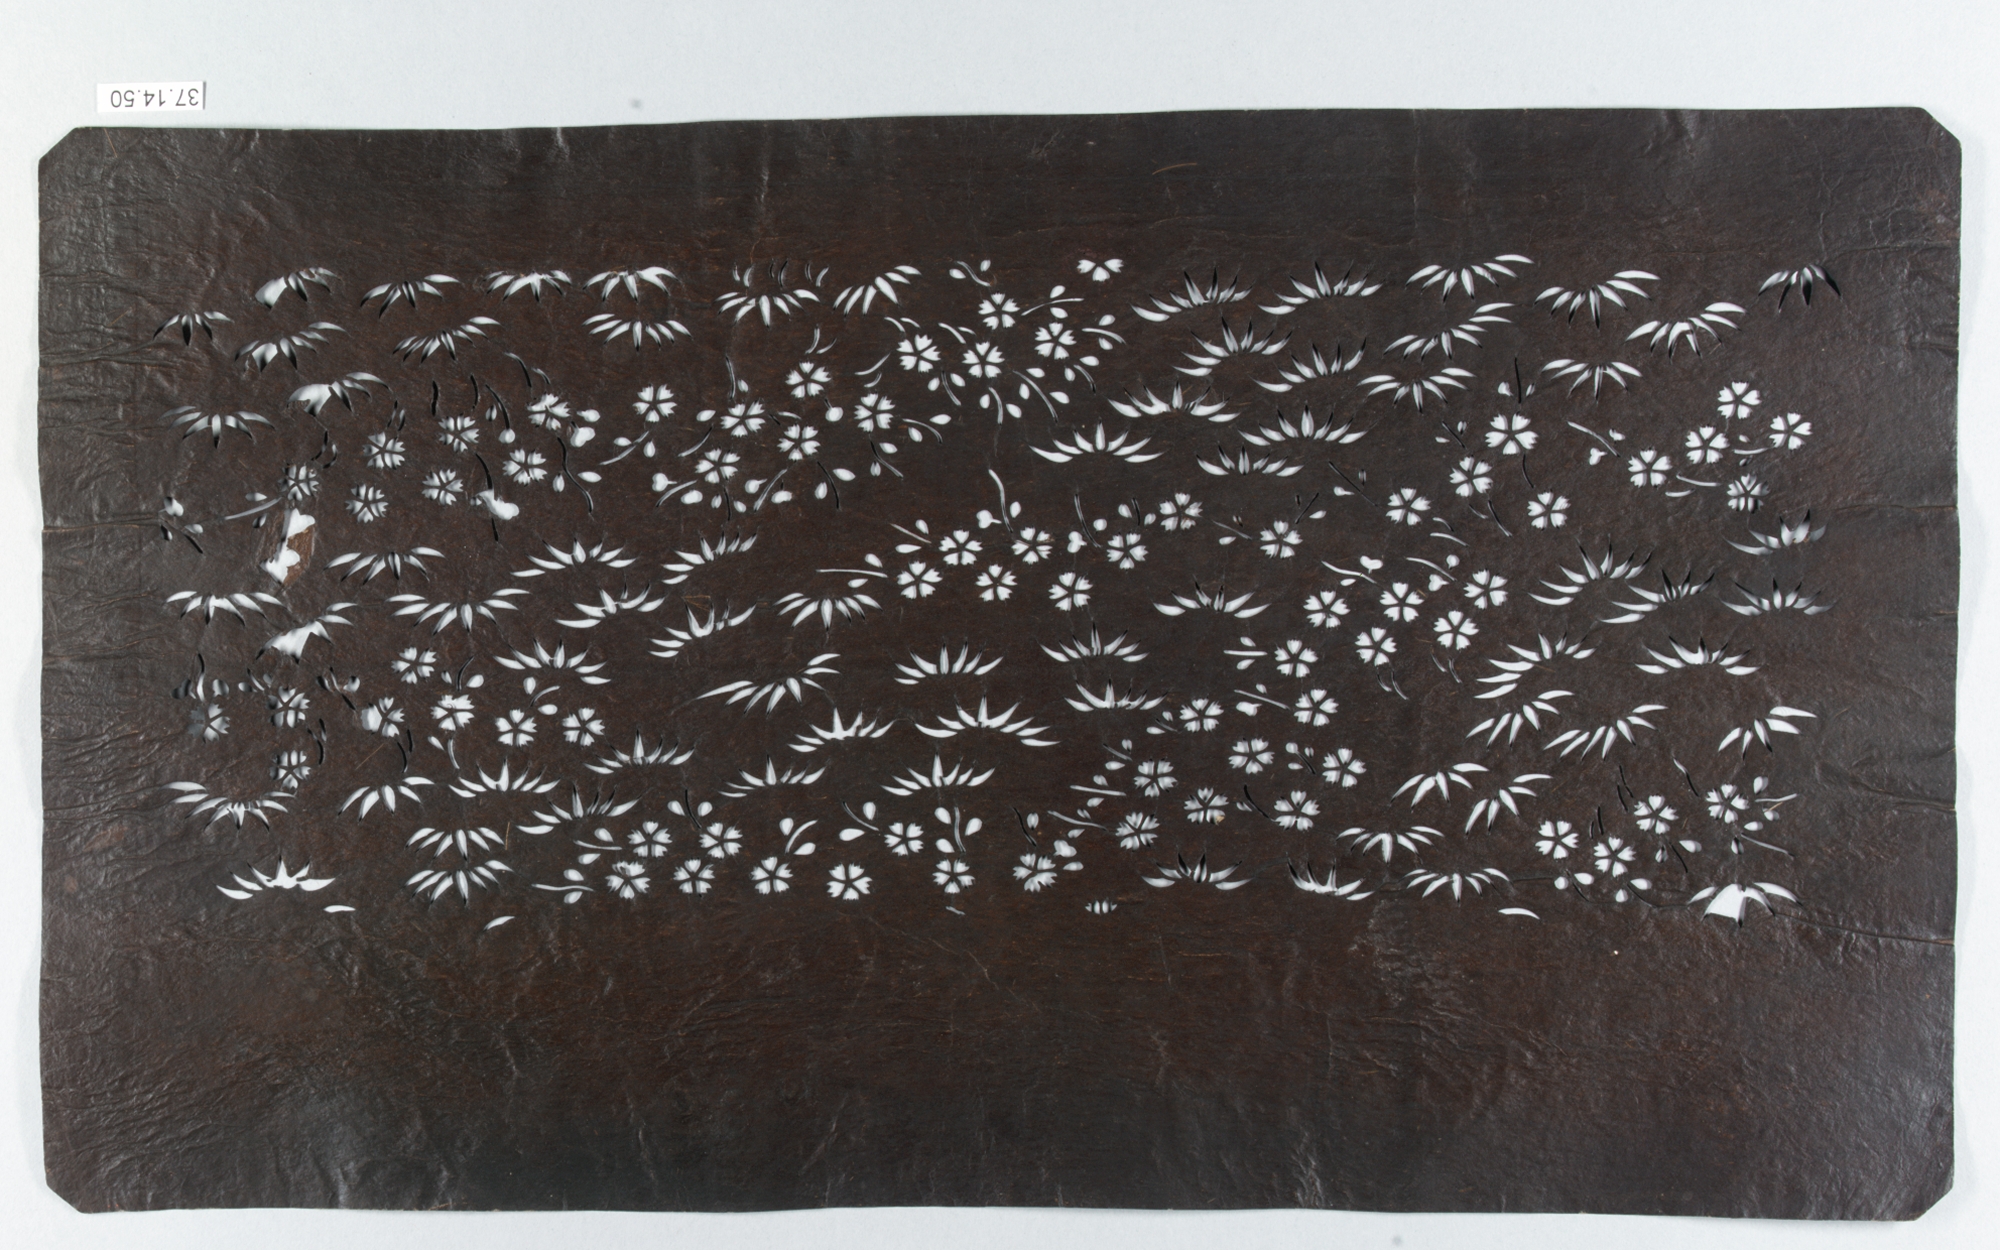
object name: stencil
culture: japanese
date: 1801-1833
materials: paper